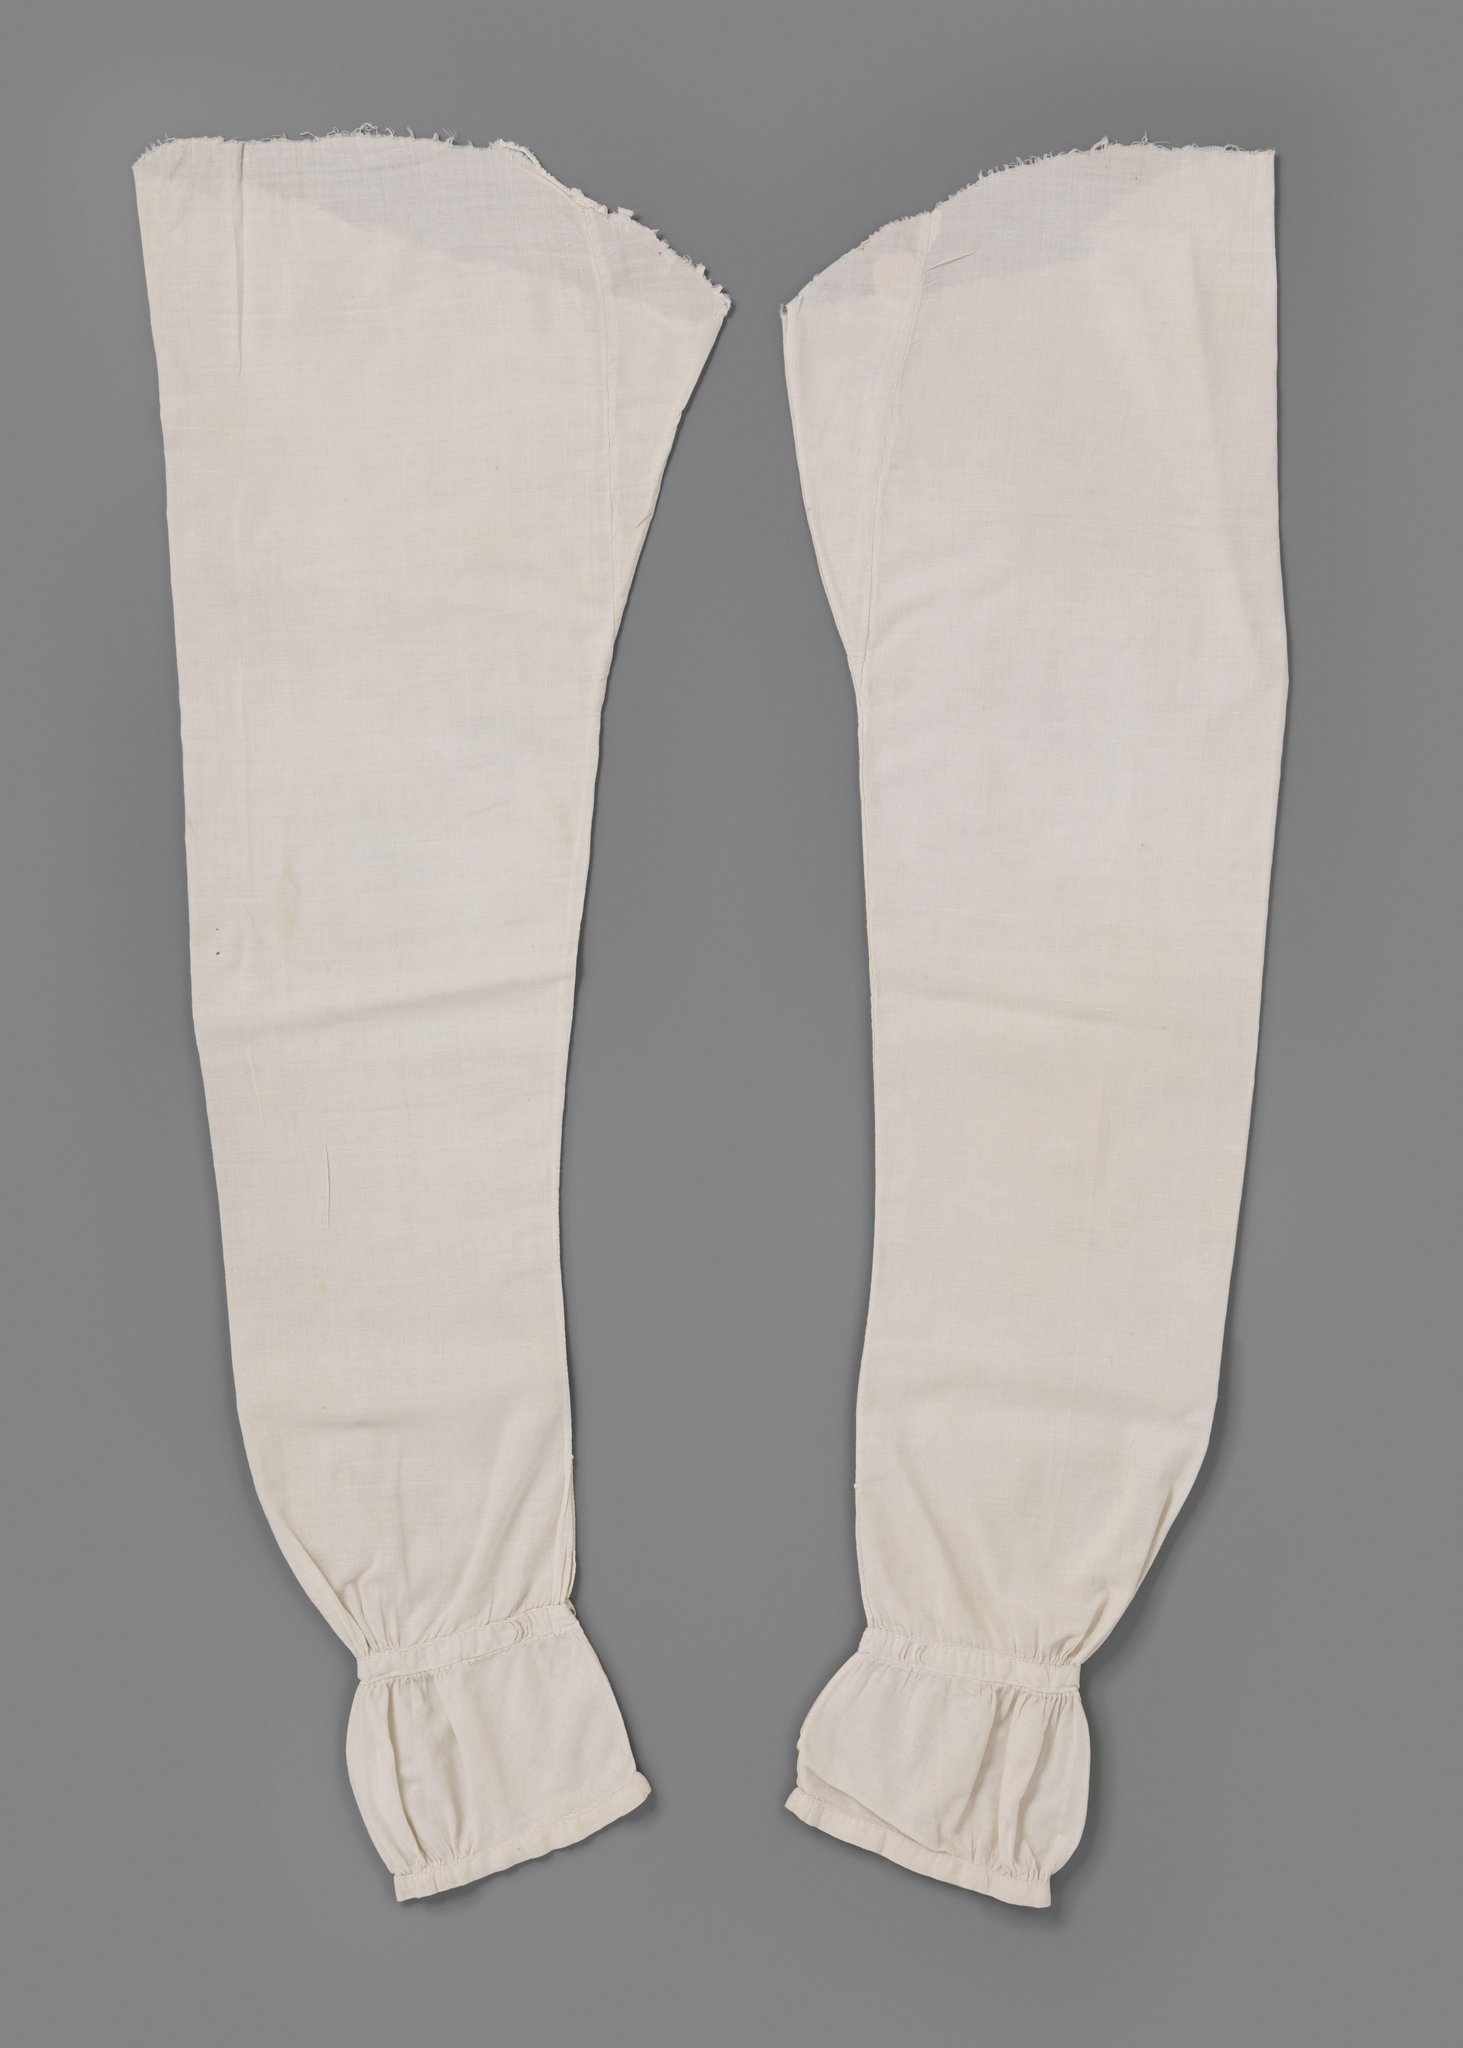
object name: undersleeve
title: Ondermouw van wit linnen met dof aan de hand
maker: Anonymous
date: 1800-1850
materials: linen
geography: western europe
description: Ondermouw, afgetornd, van wit linnen met dof aan de hand.